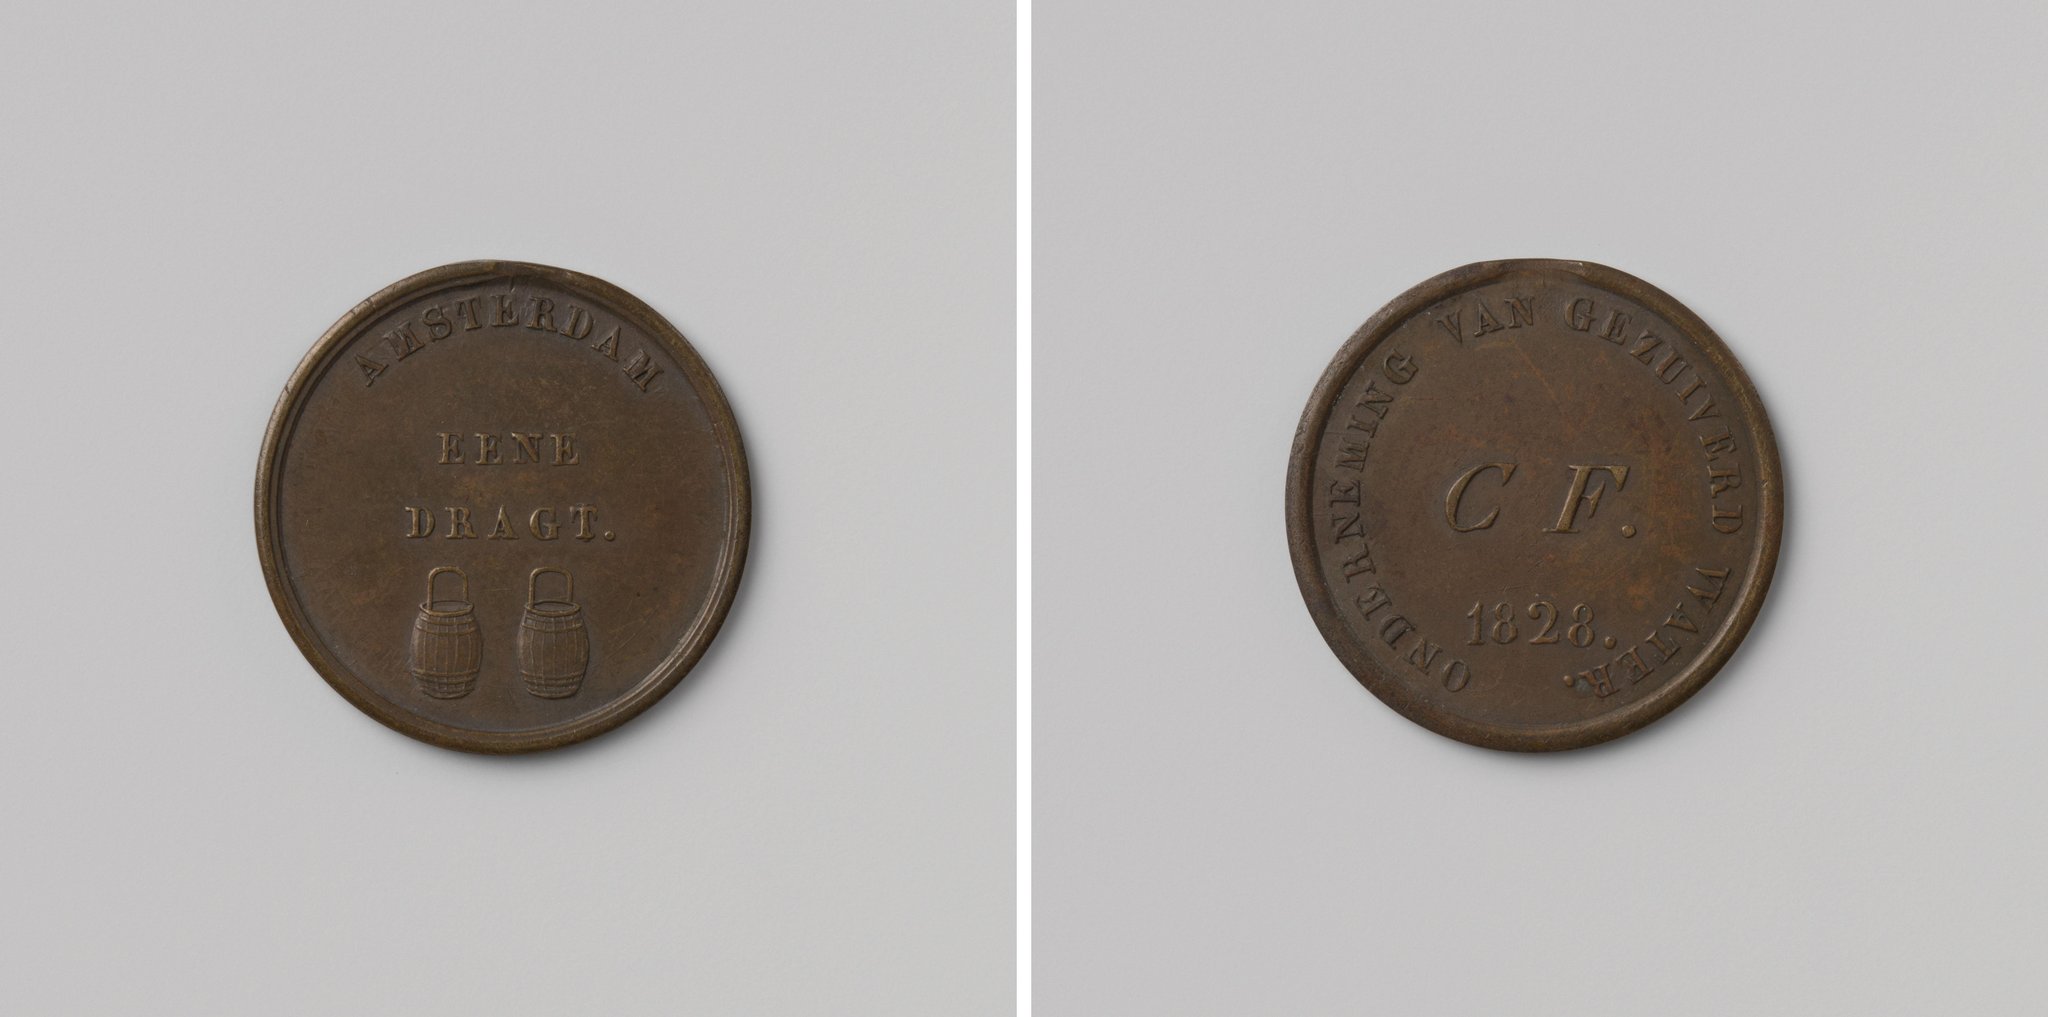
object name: armenloodje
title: Onderneming van gezuiverd water te Amsterdam, loodje goed voor een dragt water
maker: Anonymous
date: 1828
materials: copper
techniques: striking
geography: amsterdam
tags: amsterdam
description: Koperen penning. Voorzijde: twee wateremmers onder opschrift binnen omschrift. Keerzijde: letters C.F boven jaartal binnen omschrift.